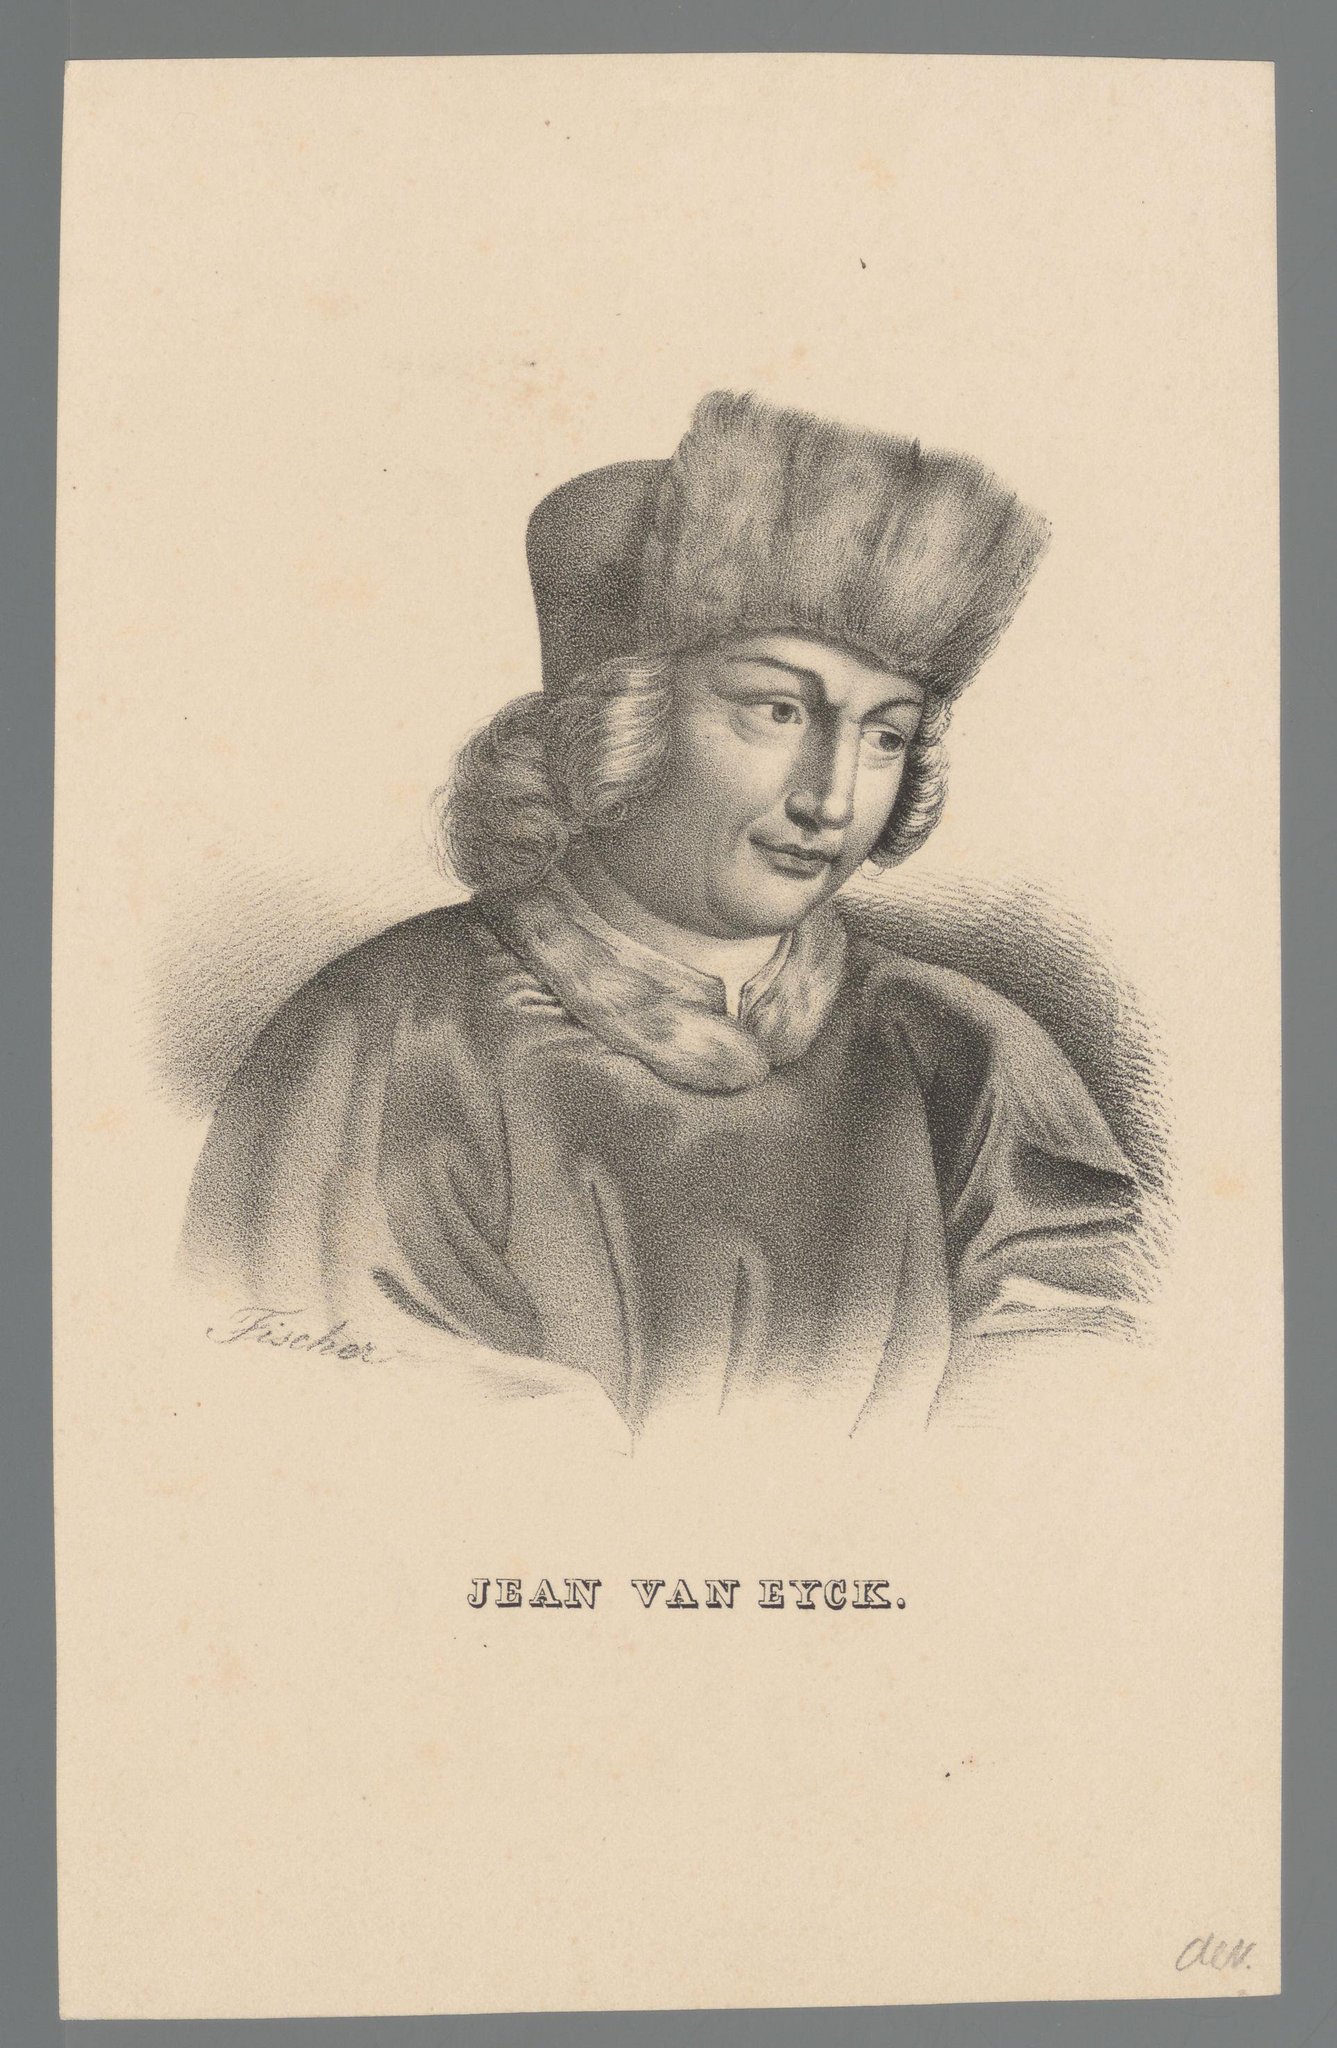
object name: print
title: Portret van Jan van Eyck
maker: h. fischer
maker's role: print maker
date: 1830-1860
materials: paper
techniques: lithograph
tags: bruges, draughtsman, jan van eyck, historical persons, portrait, self-portrait of painter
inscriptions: collector's mark: Lugt 2228